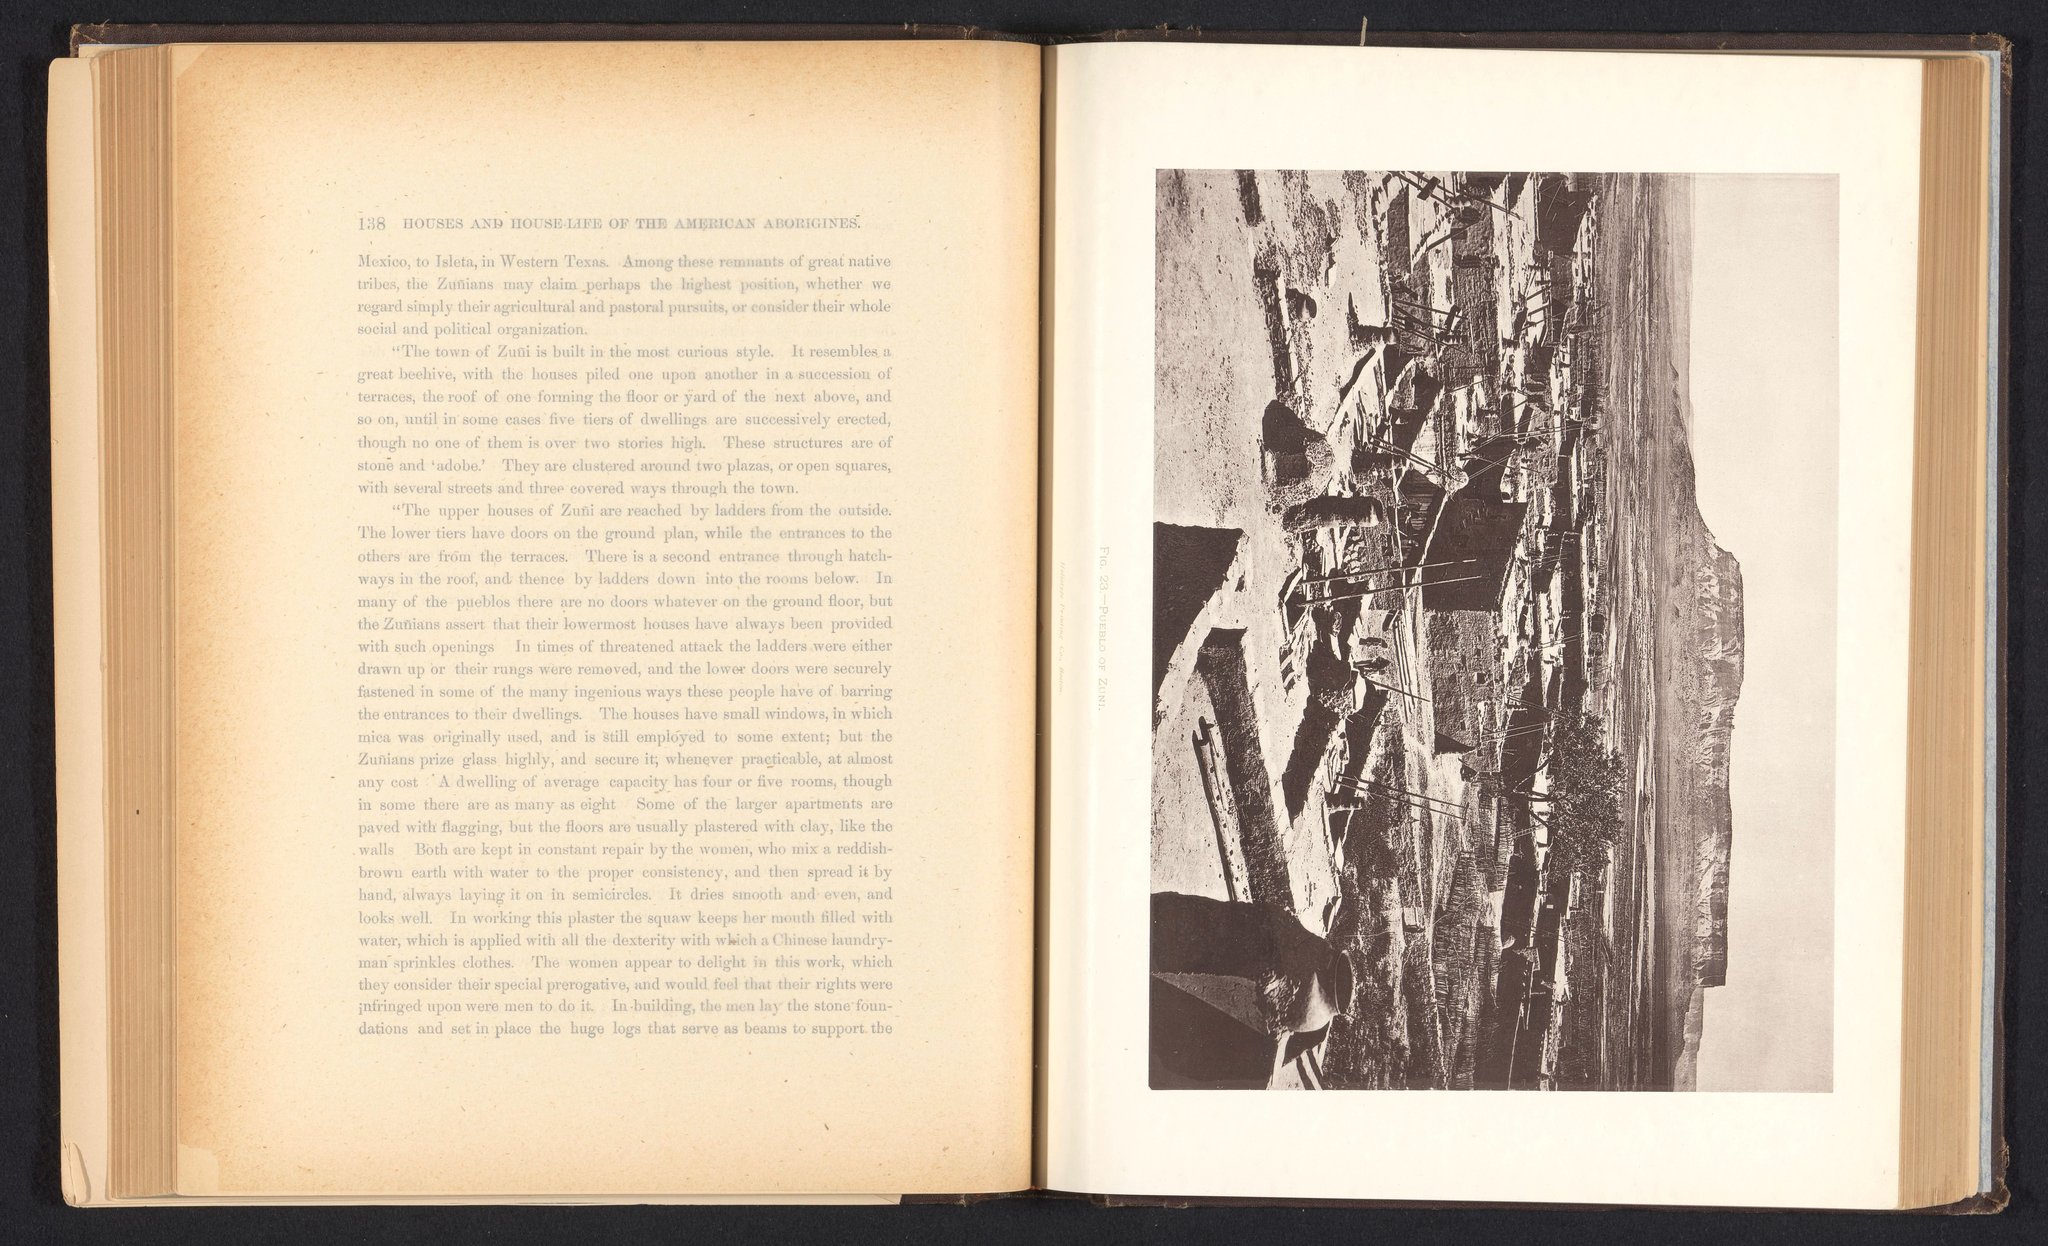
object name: photomechanical print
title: Pueblo of Zuni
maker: john karl hillers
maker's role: fotograaf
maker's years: 1843-1925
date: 1876-1881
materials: paper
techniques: photograph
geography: boston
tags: city-view in general; 'veduta'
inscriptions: number: ‘Fig. 23.’